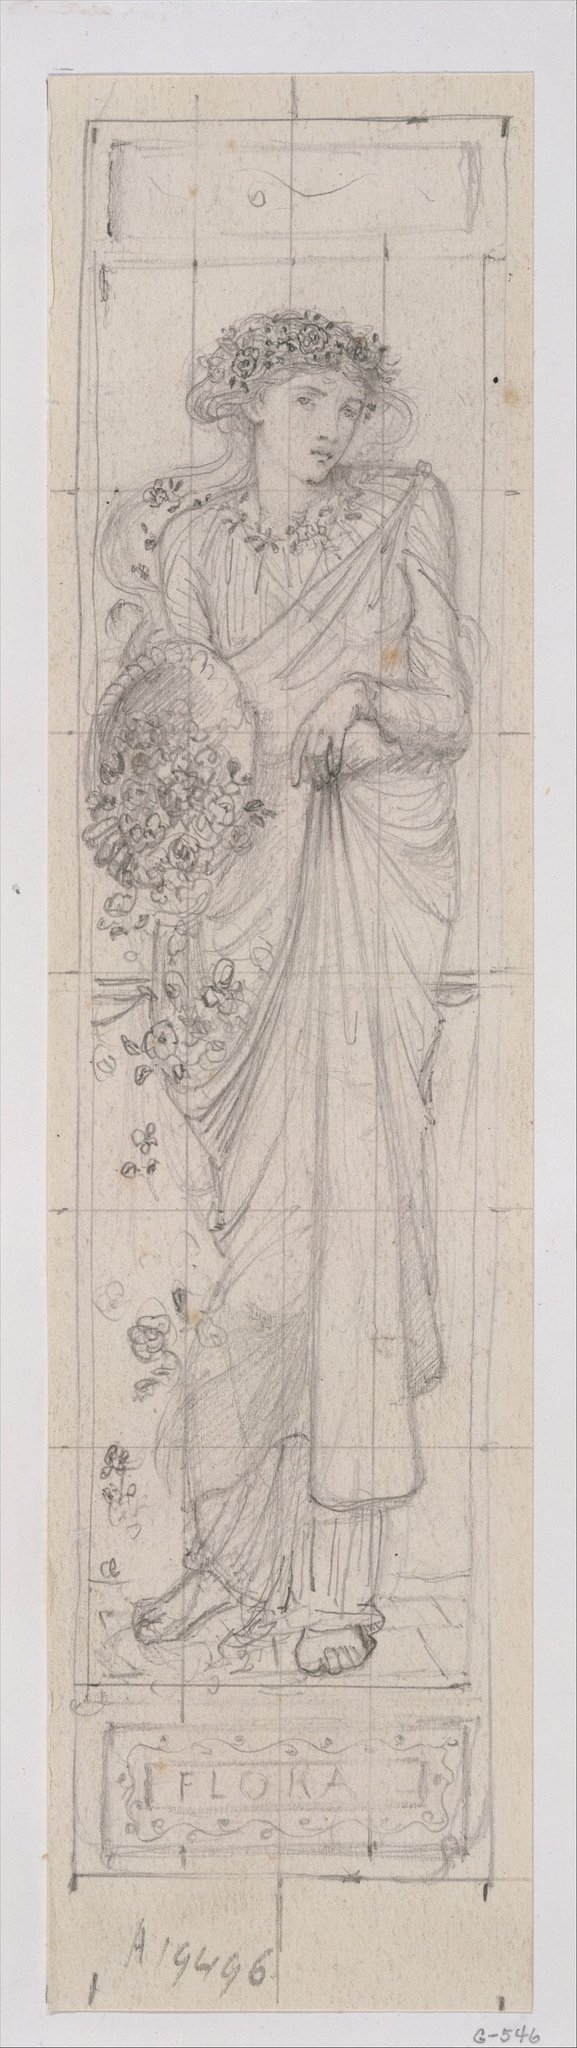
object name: drawing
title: Design for the Figure of "Flora"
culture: british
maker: sir edward burne-jones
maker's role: artist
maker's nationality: british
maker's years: 1833-1898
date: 1801-1900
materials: graphite, paper